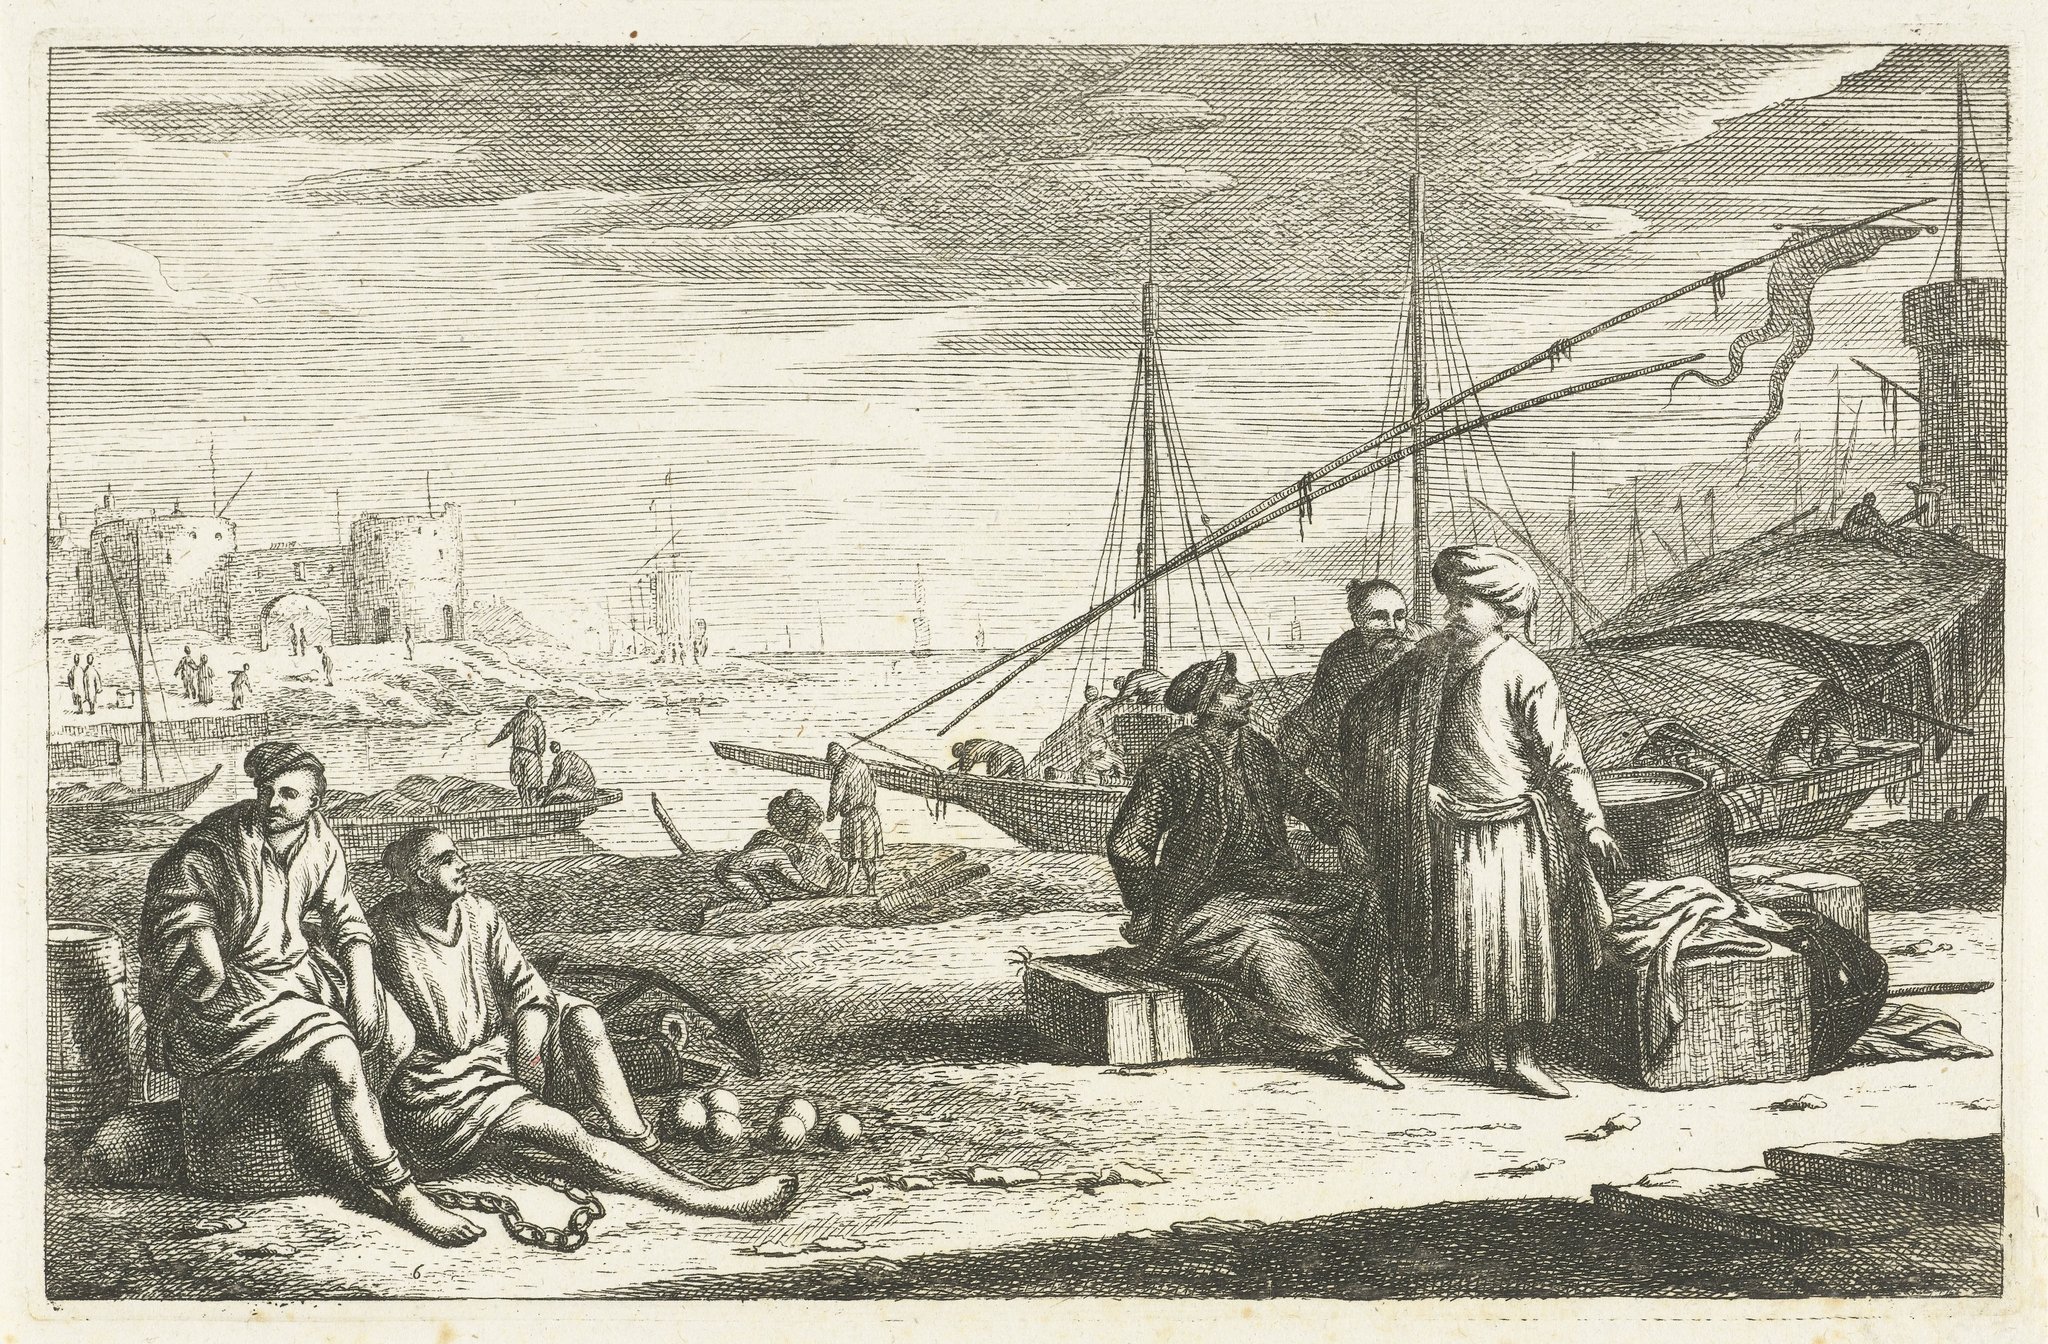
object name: print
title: Haven met kooplieden en gevangenen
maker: johannes gronsveld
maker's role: draughtsman, painter, print maker, publisher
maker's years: 1658-1728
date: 1679-1728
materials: paper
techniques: engraving, etching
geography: amsterdam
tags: harbour (+ four persons or more ~ traffic and transport)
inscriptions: collector's mark: Lugt 240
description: Haven met rechts buitenlandse kooplieden met een lading; daarachter een zeilschip. Links twee buitenlandse gevangenen, aan de voeten vastgeketend met een ketting. Links op de achtergrond een stadspoort. Zesde prent uit een serie van twaalf met Italiaanse havens.